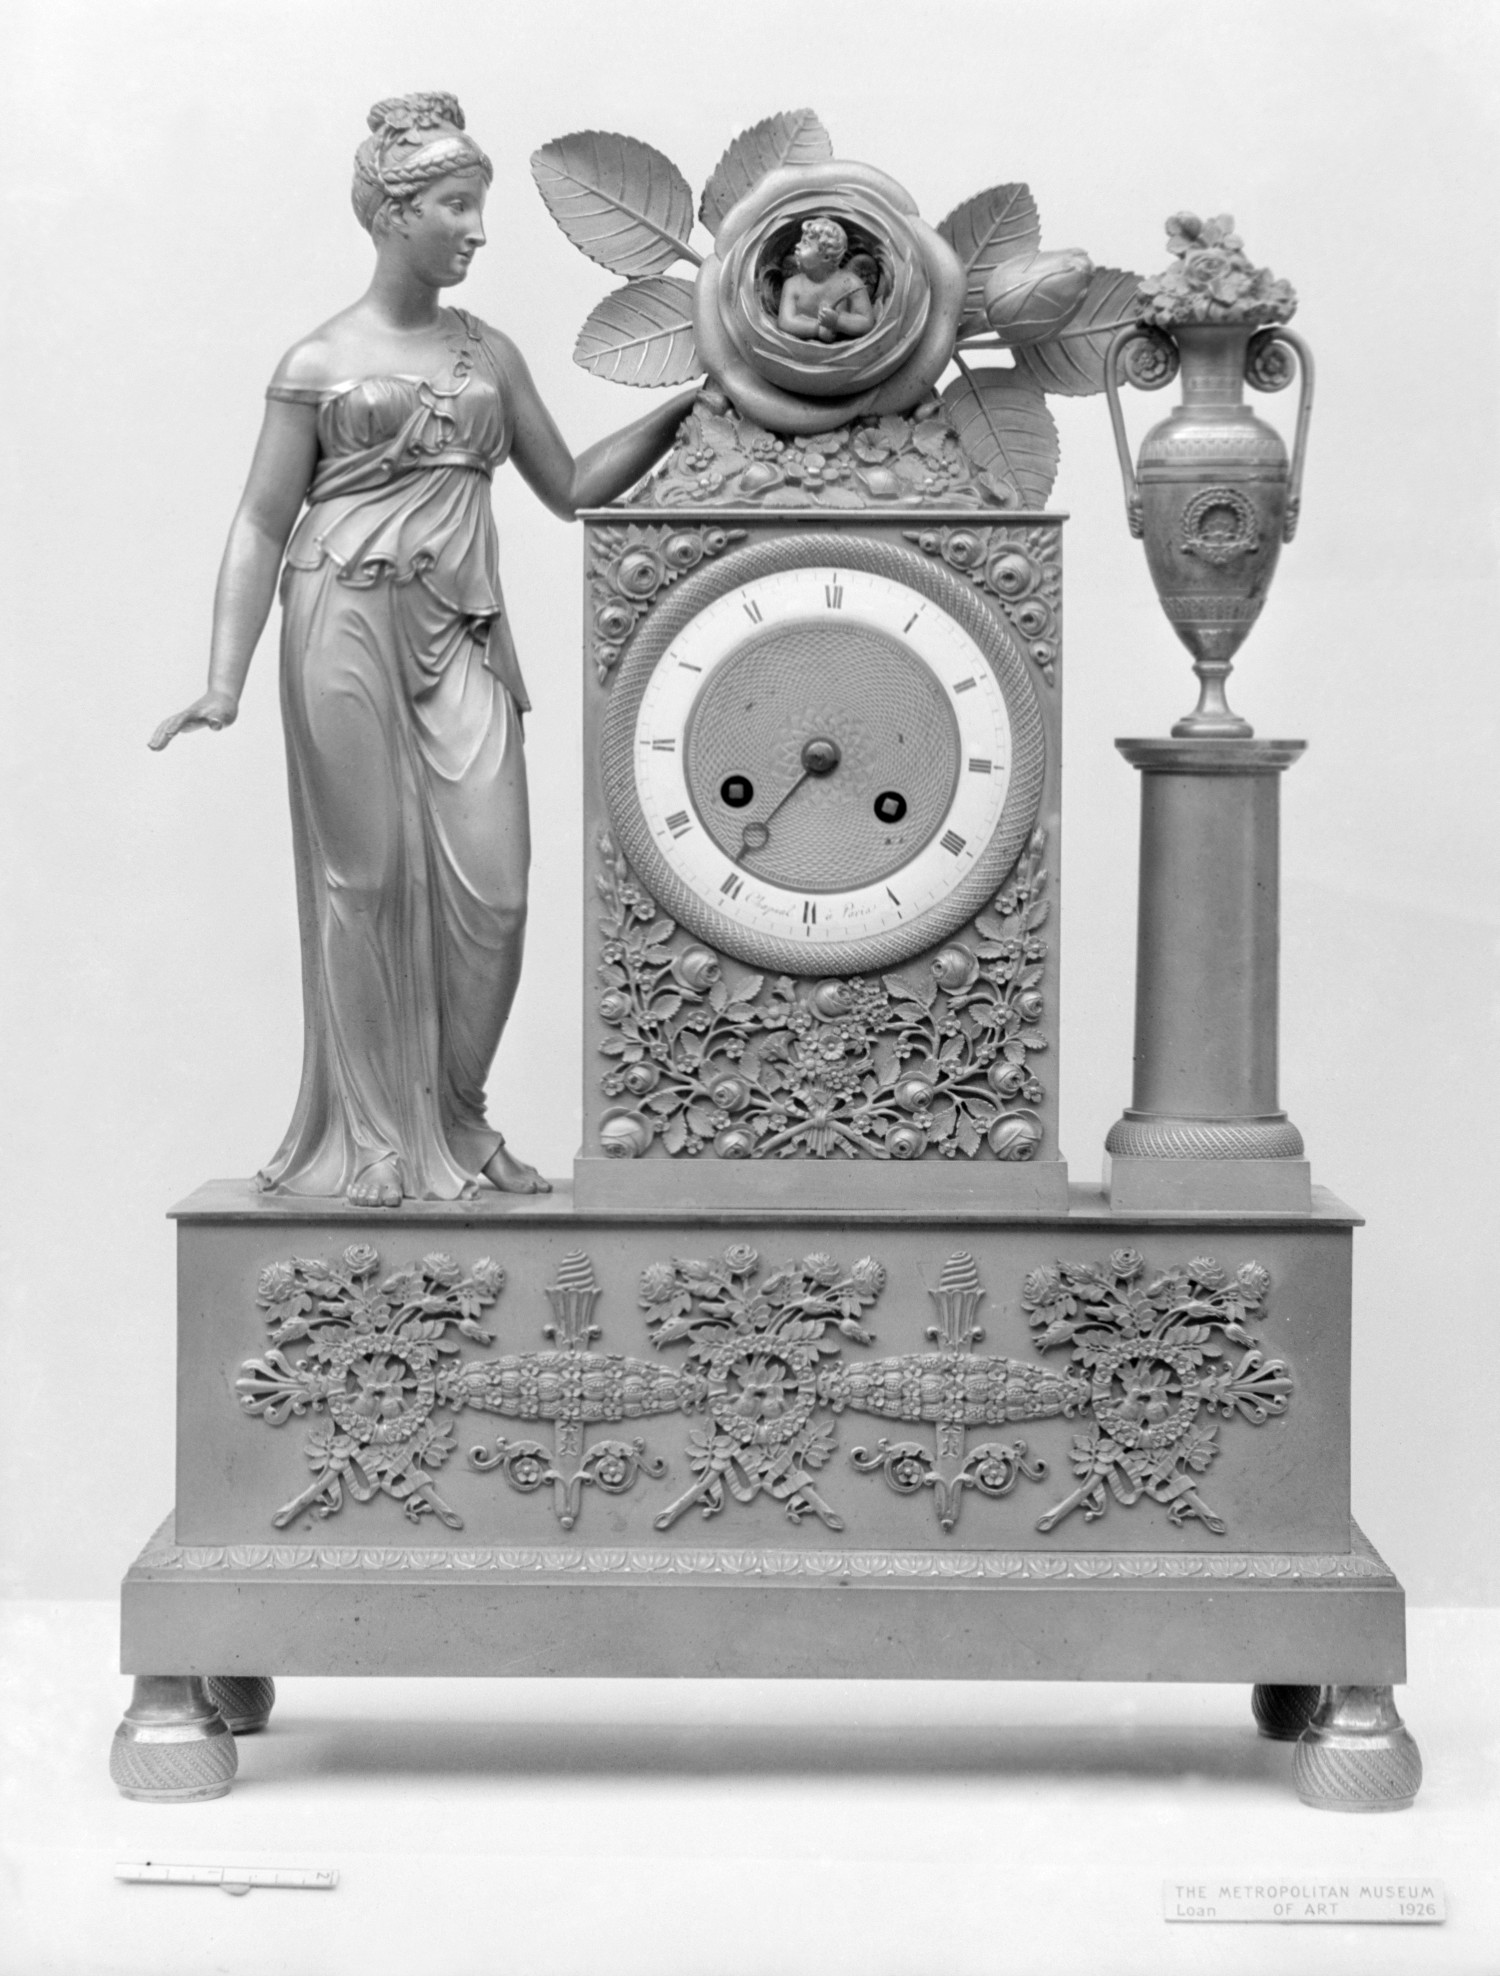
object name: clock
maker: chapsal l'ainé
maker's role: maker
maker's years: 1782-1850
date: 1815-1830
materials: gilt bronze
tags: women,flowers